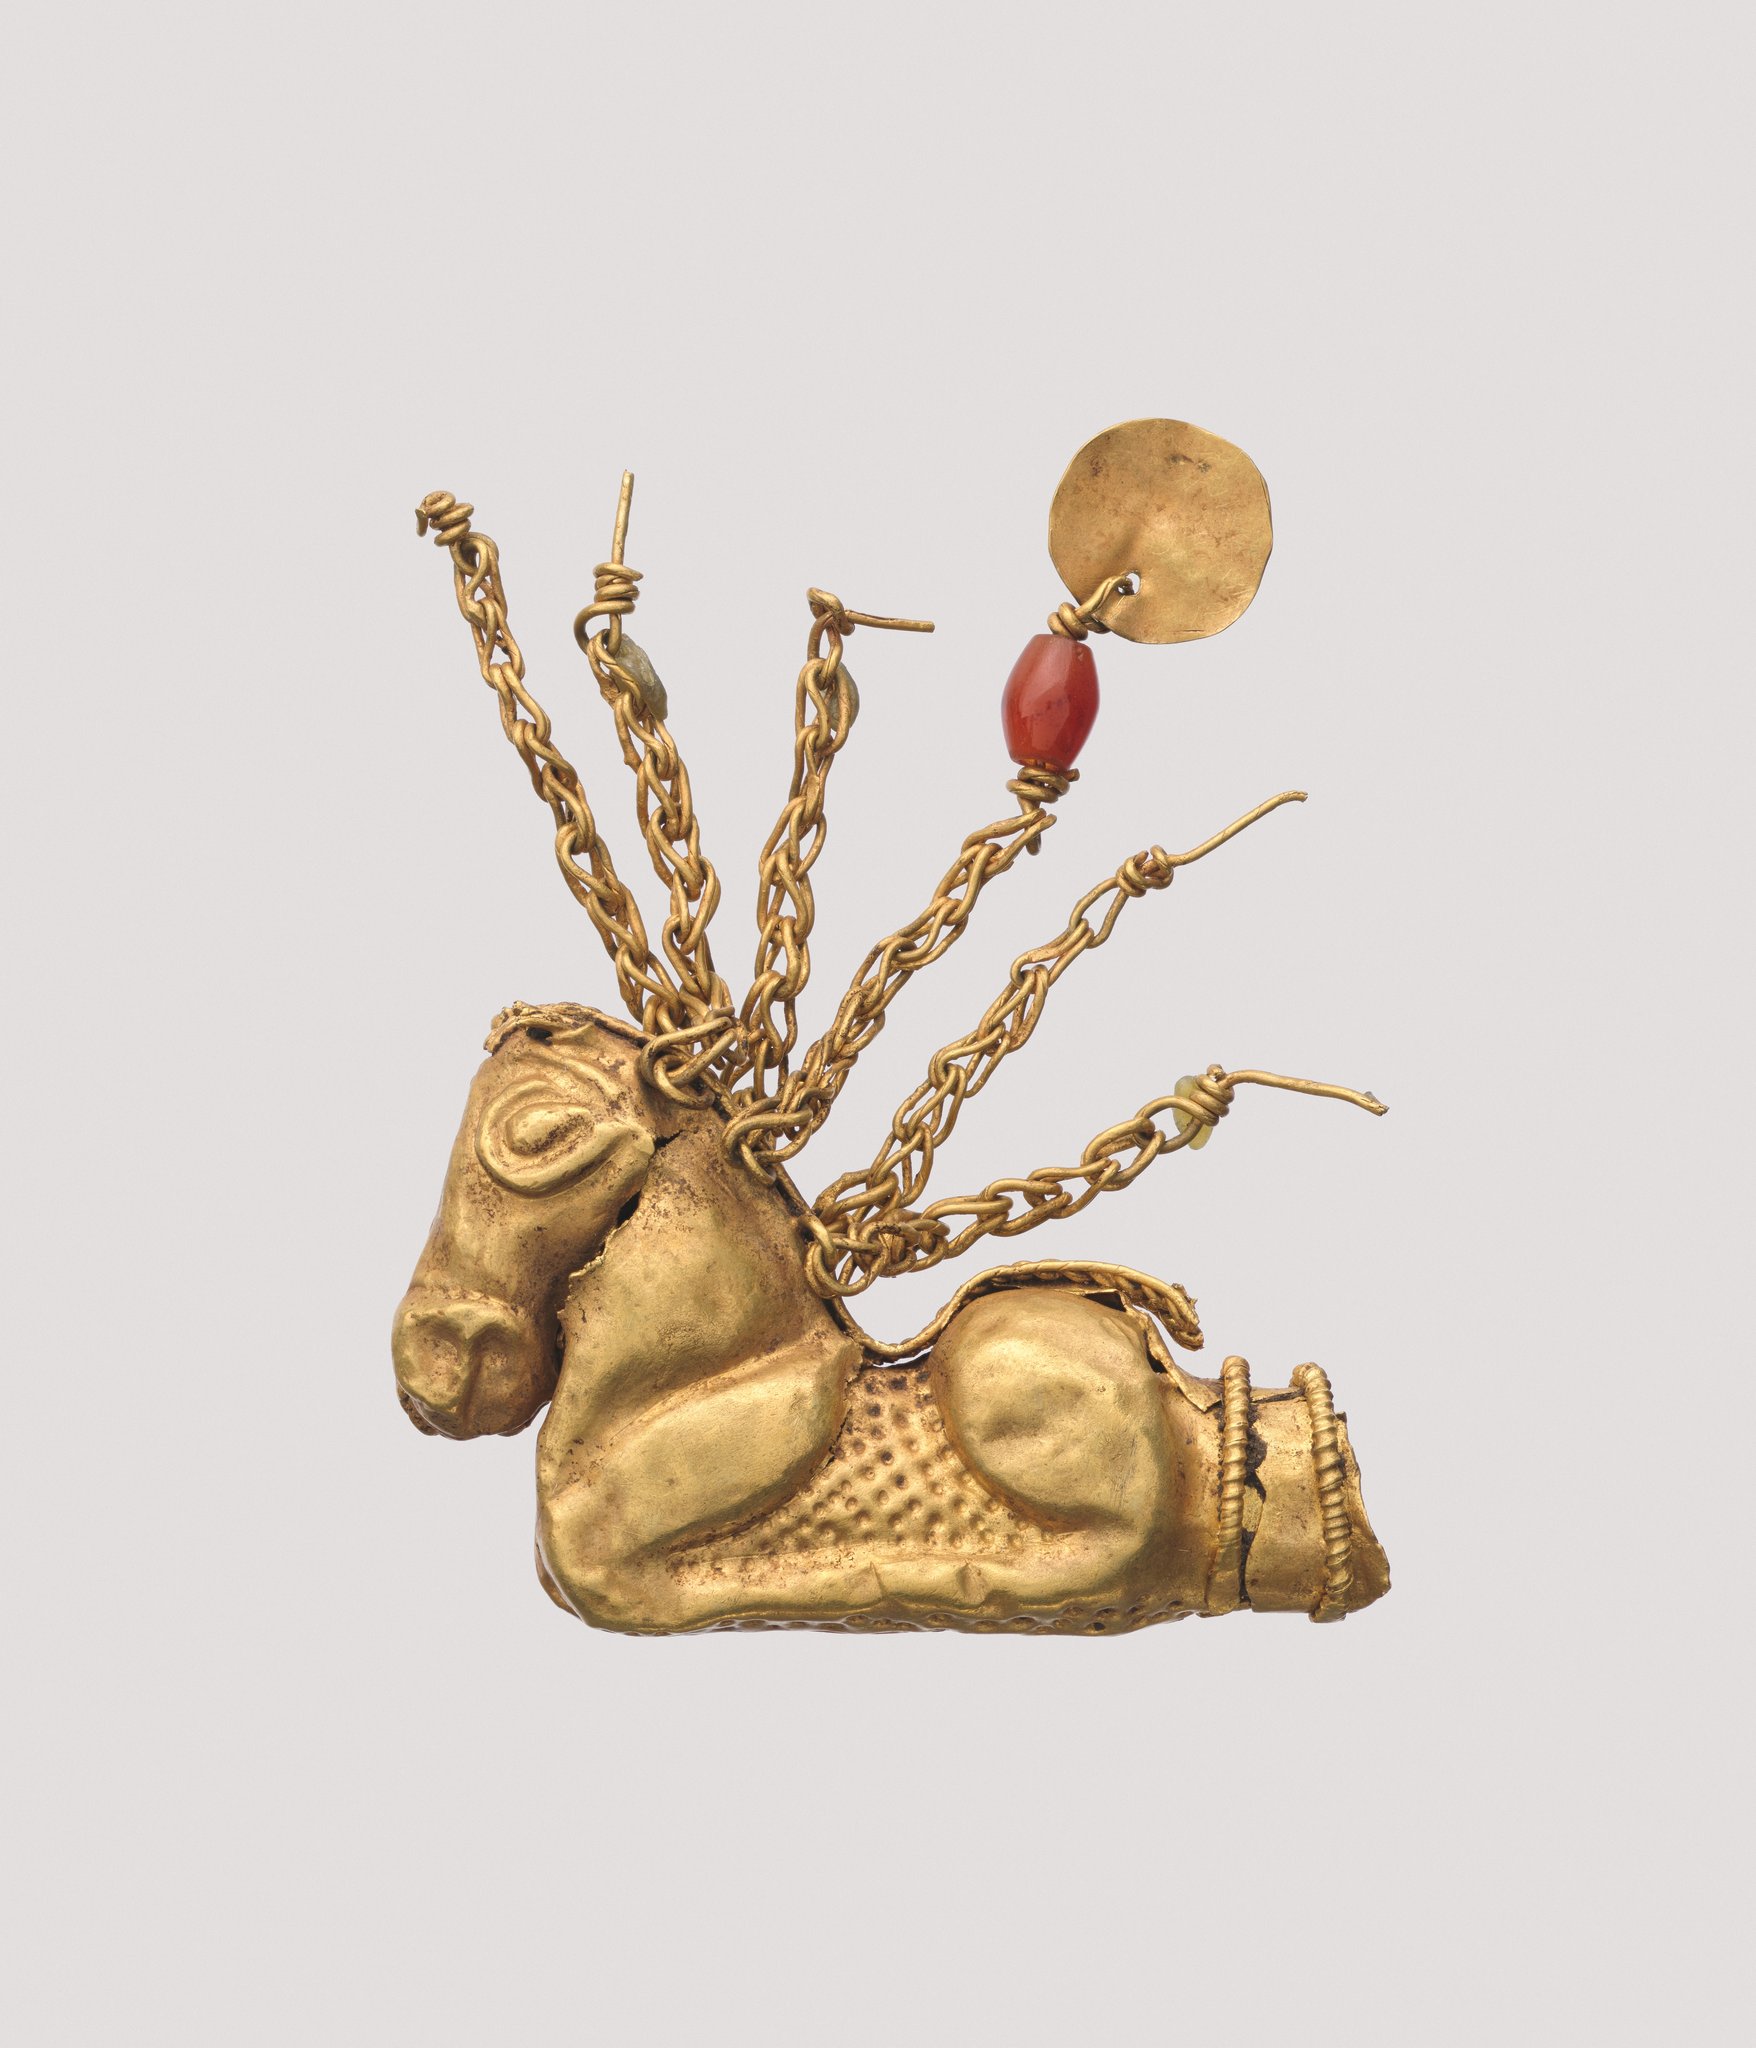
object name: pendant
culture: scytho-sarmatian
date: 400-201 BCE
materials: gemstone, gold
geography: eurasian steppes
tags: horses